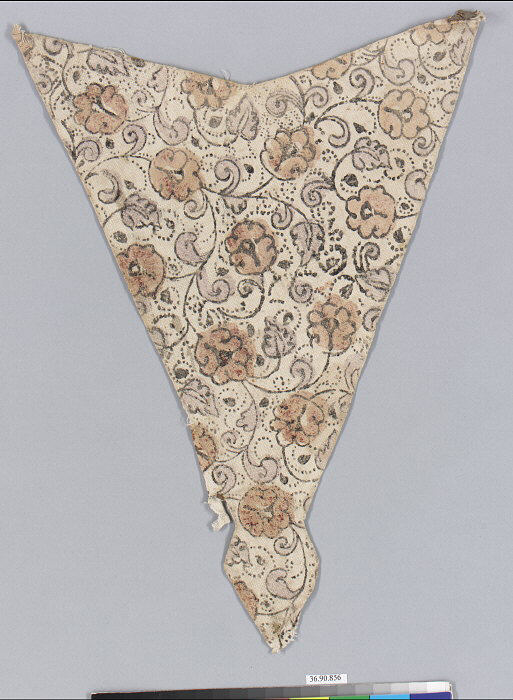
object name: piece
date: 1701-1800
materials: cotton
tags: flowers,leaves